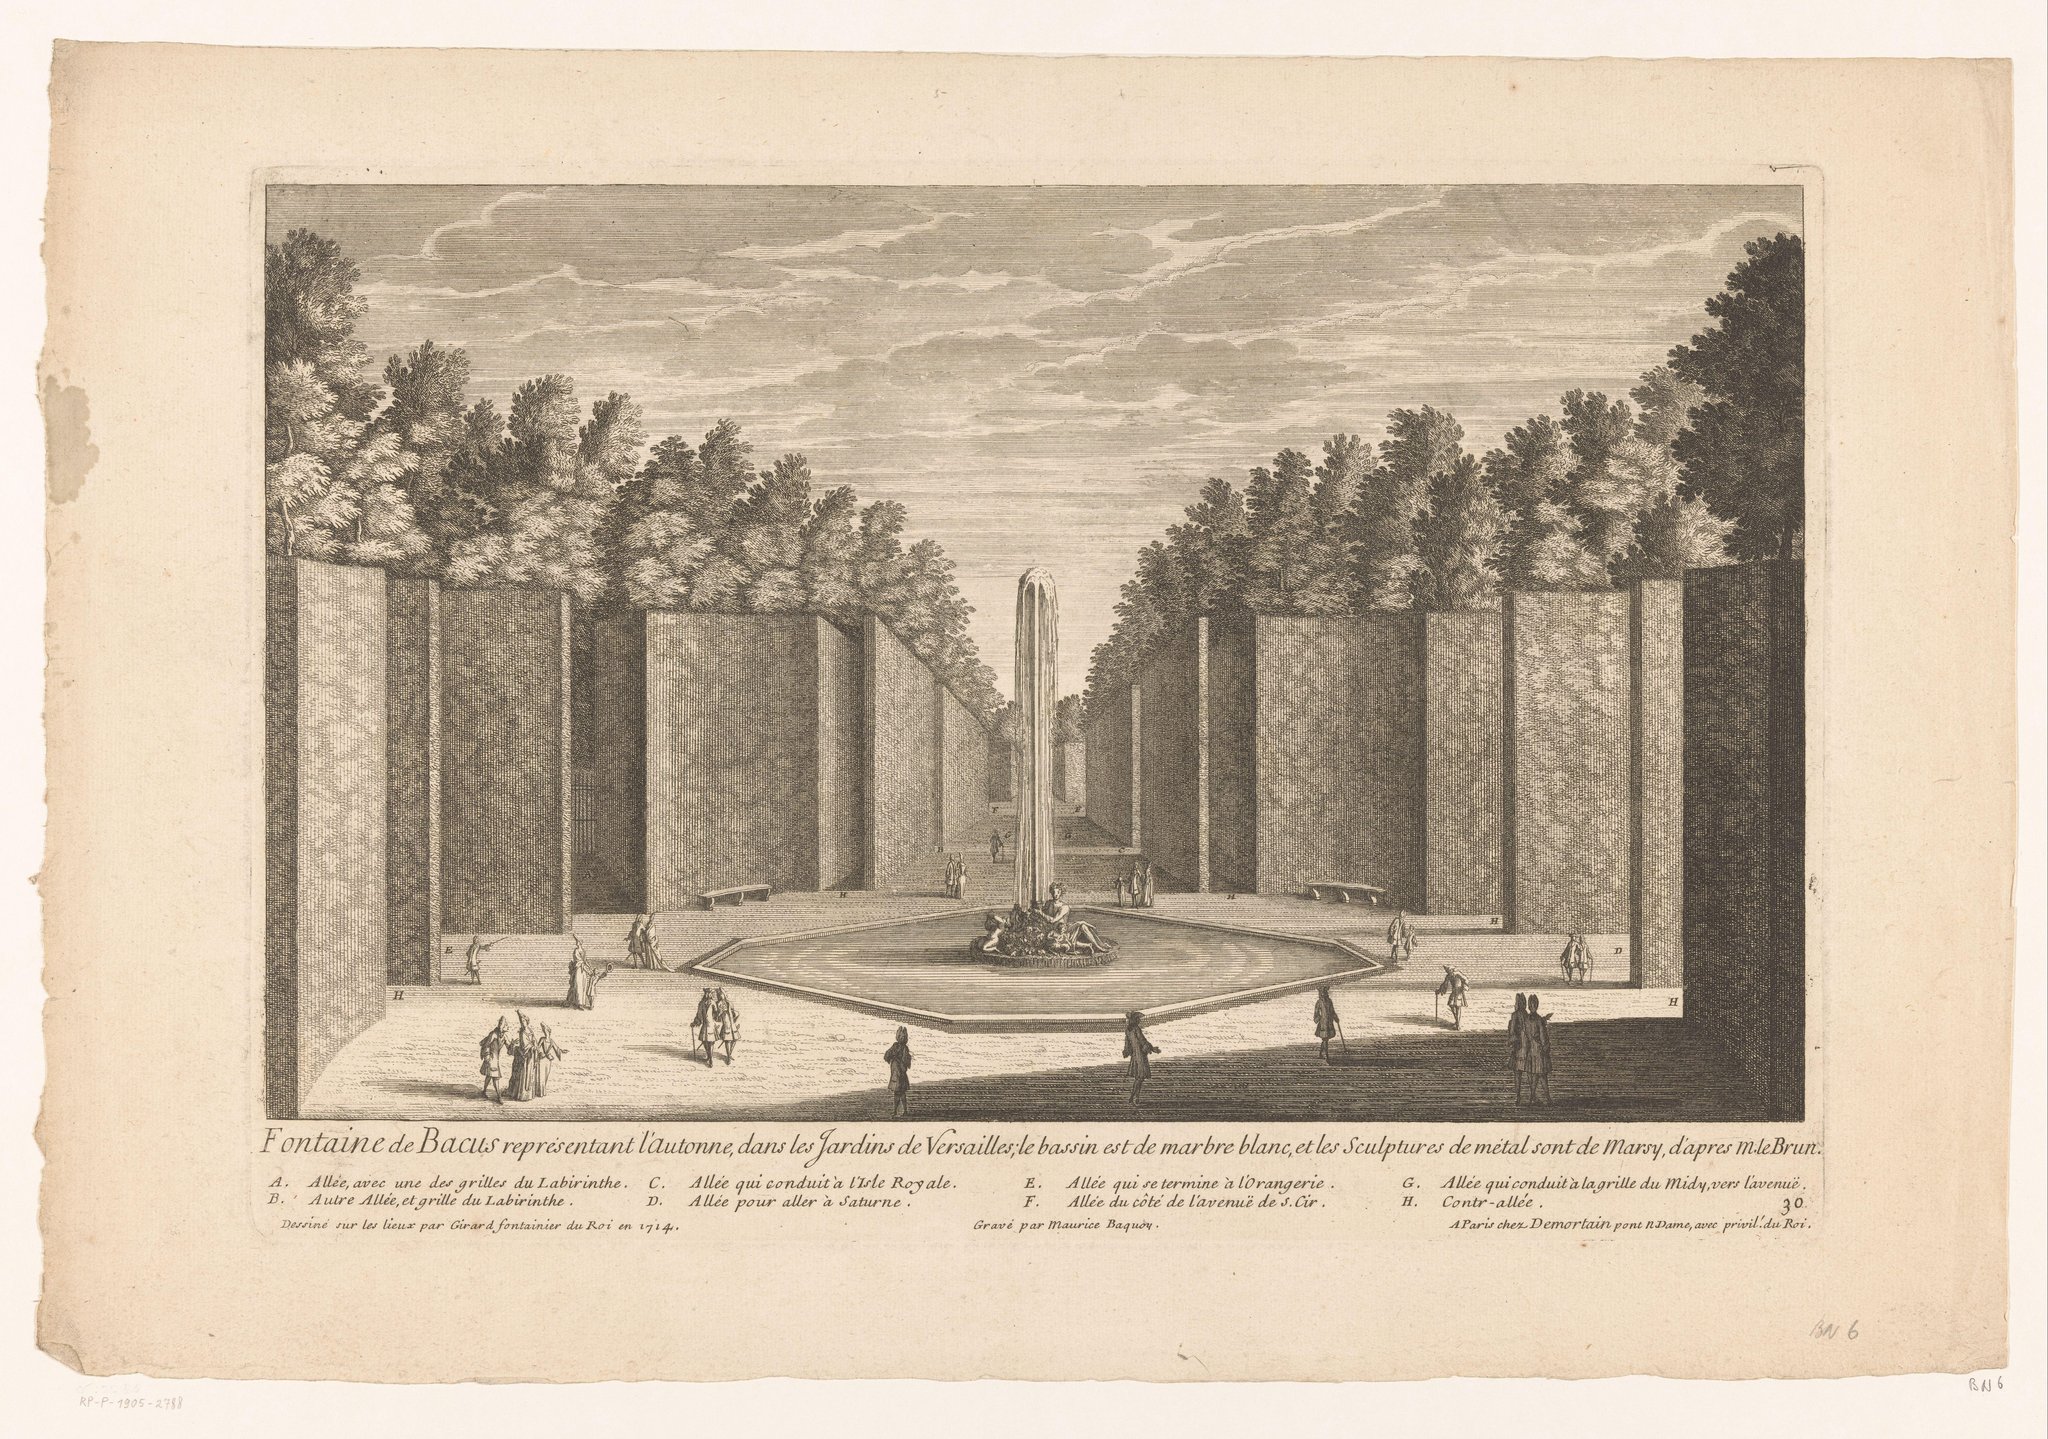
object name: print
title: Fontaine de Bacus représentant l'Autonne, dans les Jardins de Versailles (...)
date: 1714-1747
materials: paper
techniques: etching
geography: paris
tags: (story of) bacchus (dionysus), liber, garden fountain, french or architectonic garden; formal garden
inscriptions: collector's mark: Lugt 2228